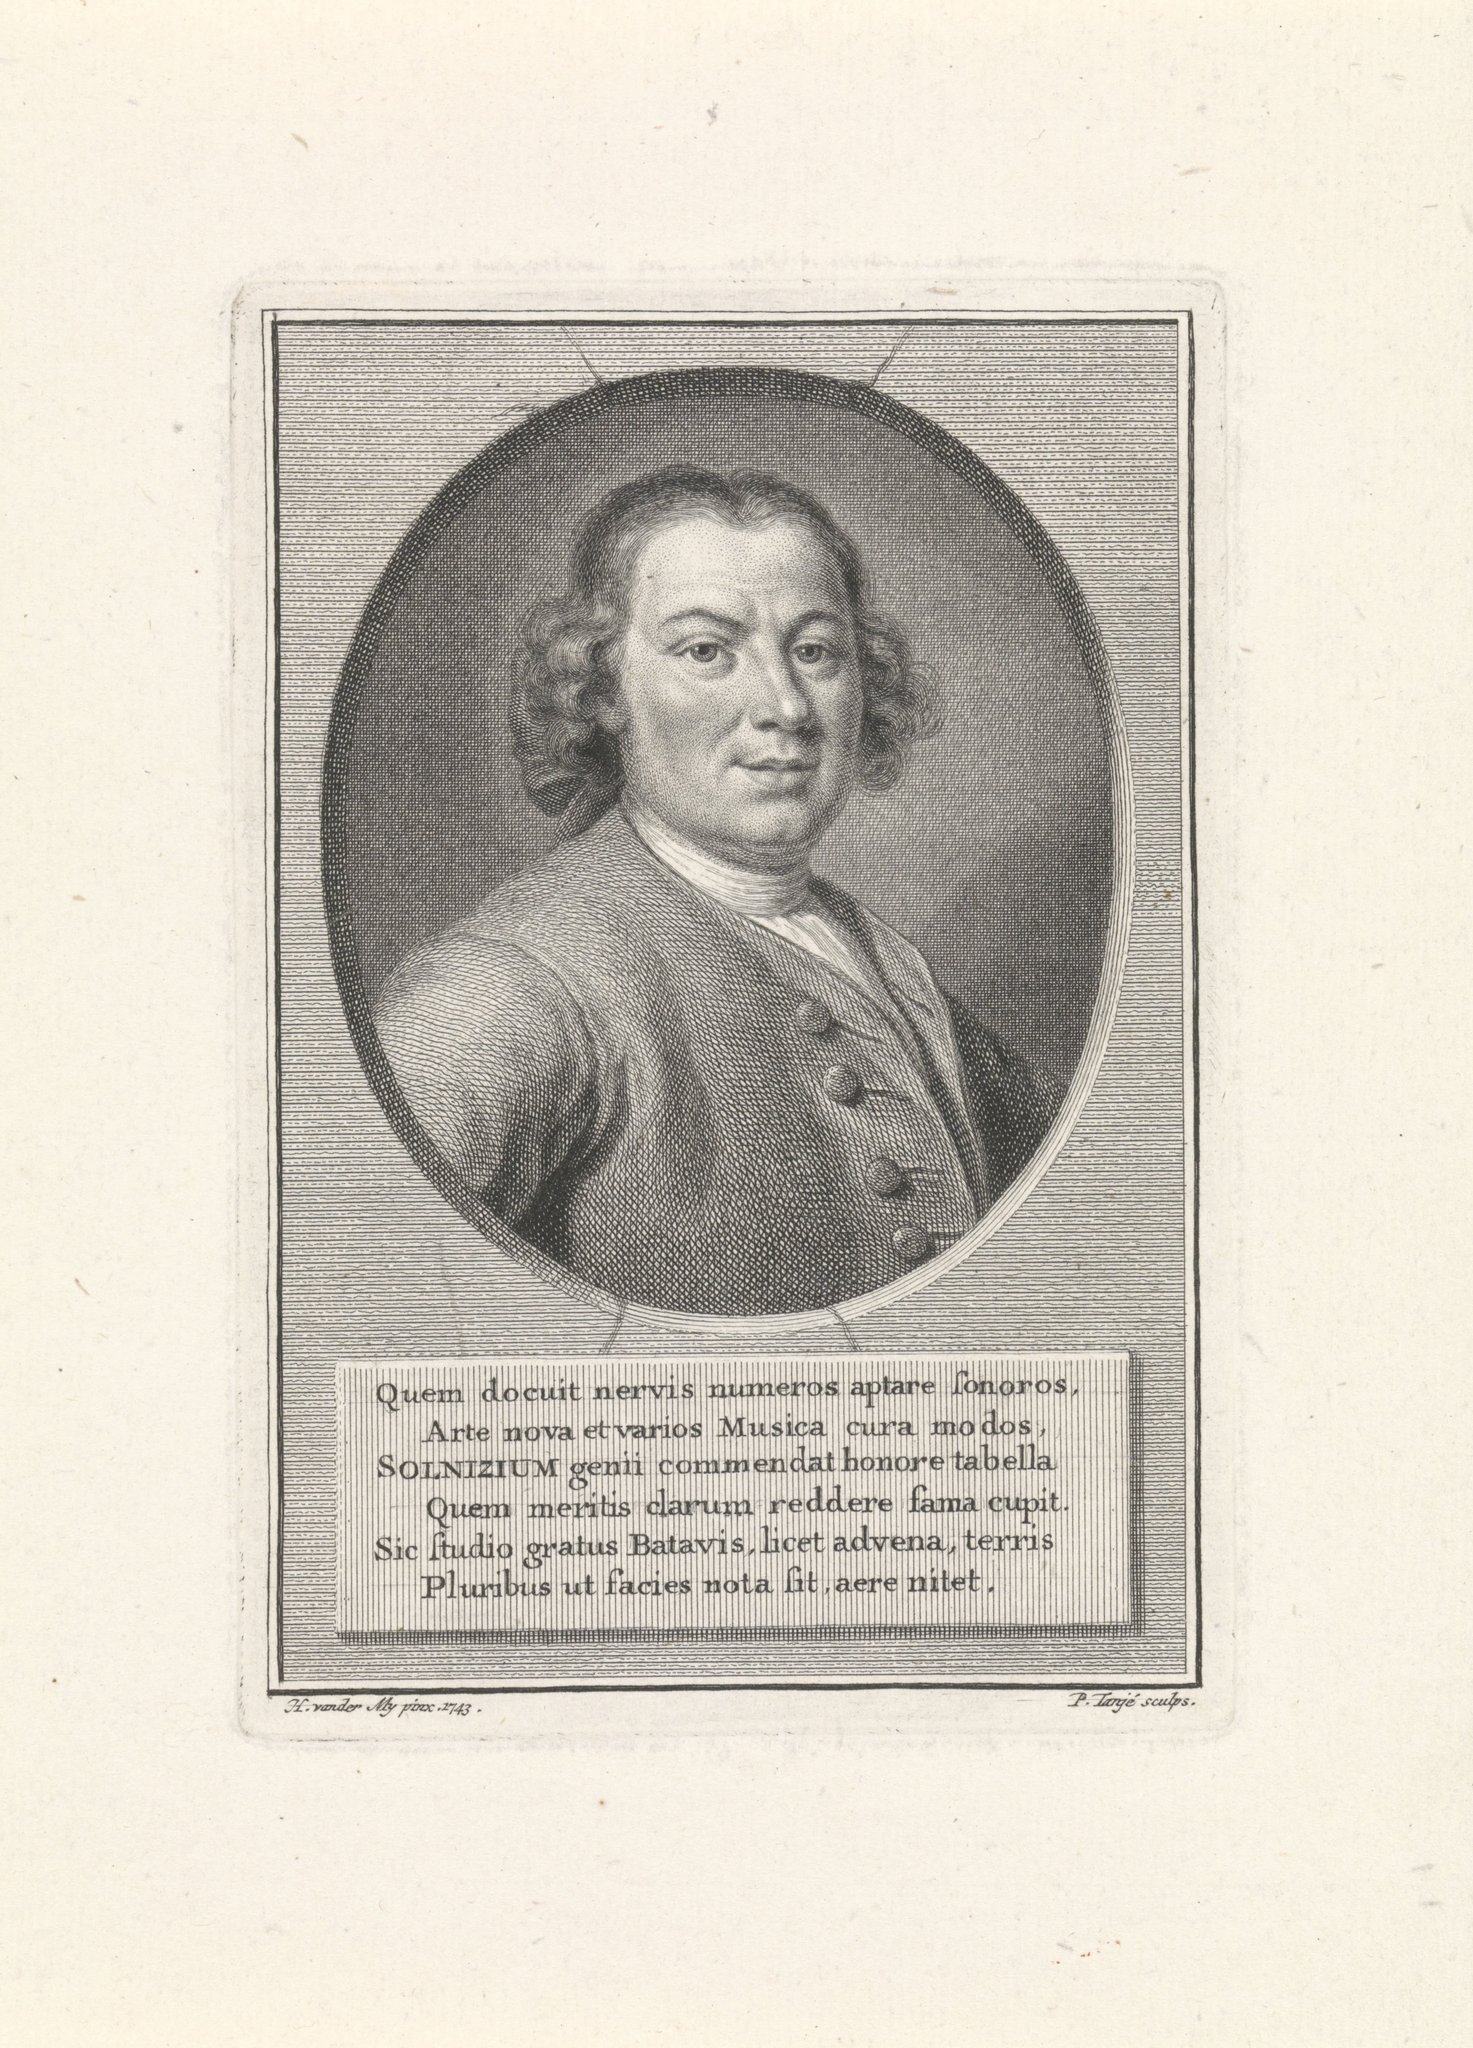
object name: print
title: Portret van Anton Wilhelm Solnitz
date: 1743-1761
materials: paper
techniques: engraving, etching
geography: amsterdam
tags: leiden, portrait of composer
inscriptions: collector's mark: Lugt 240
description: Anton Wilhelm Solnitz, Duits-Boheems musicus en componist, was werkzaam in Nederland. Onder het portret een zesregelige tekst in het Latijn.